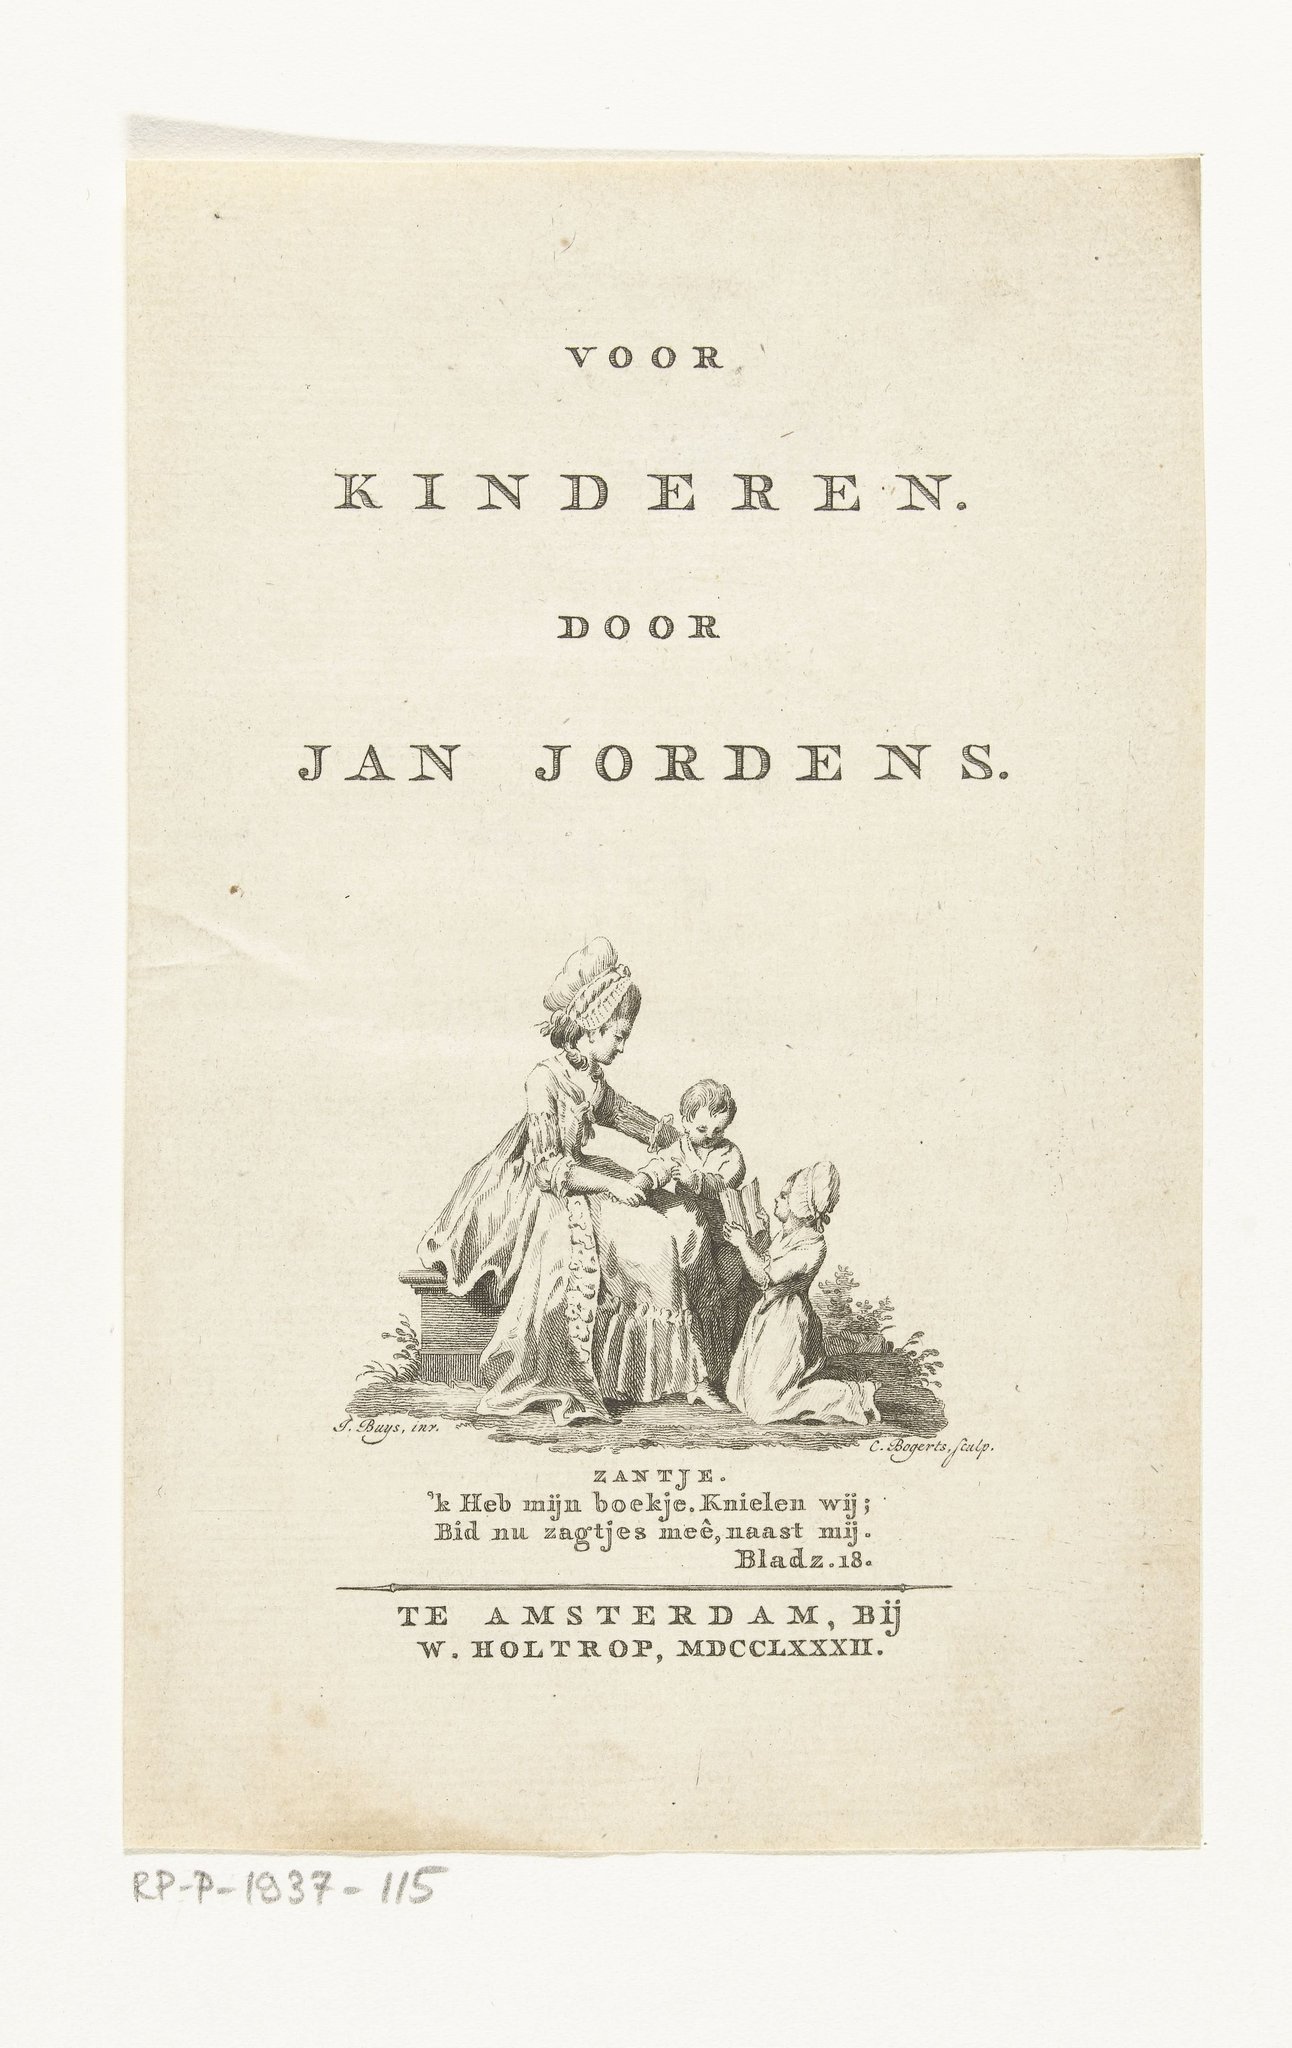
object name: print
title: Titelpagina voor: Jan Jordens, Voor kinderen. Amsterdam, 1782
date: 1782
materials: paper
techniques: etching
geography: amsterdam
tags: reading to somebody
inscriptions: collector's mark: Lugt 2760, collector's mark: Lugt 2228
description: Titelpagina voor: Jan Jordens, Voor kinderen, Amsterdam, W. Holtrop, 1782.